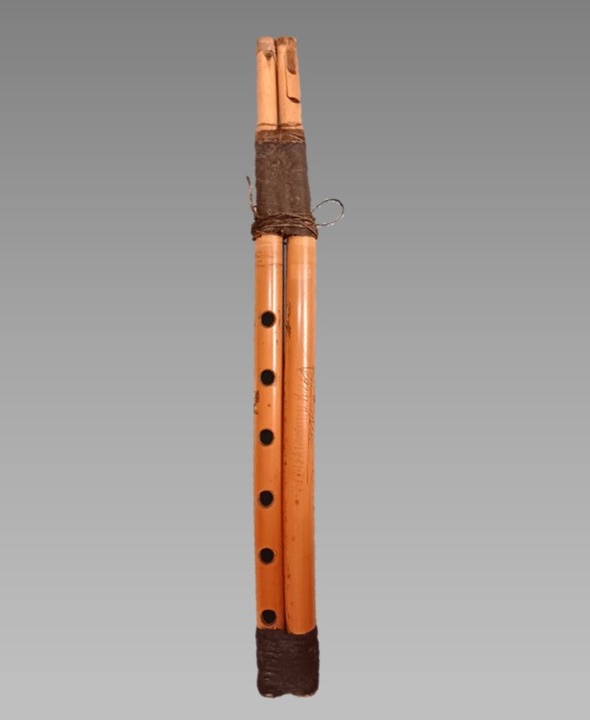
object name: mijwiz meijiwiz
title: Mijwiz (Meijiwiz)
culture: syrian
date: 1867-1900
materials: bamboo, cord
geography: syria